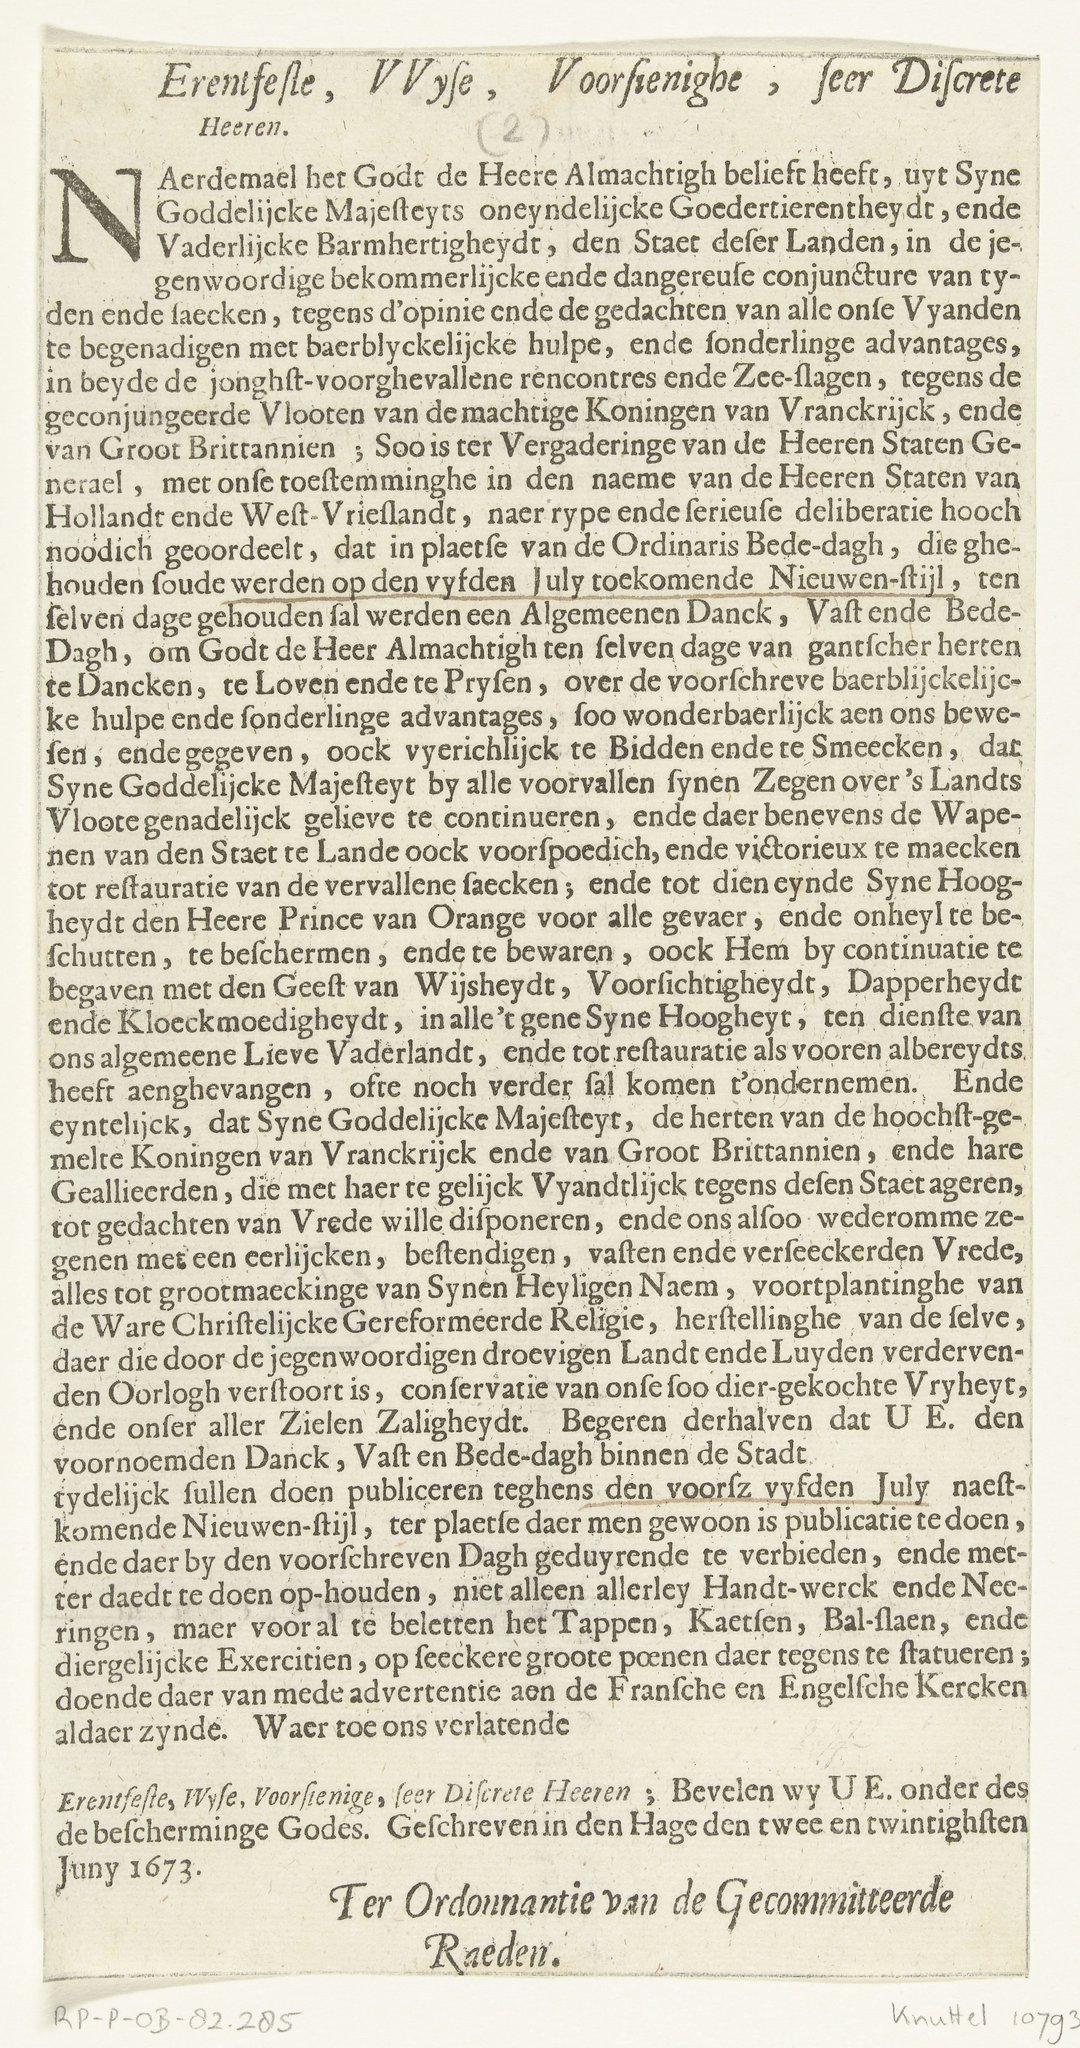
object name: text sheet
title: Uitschrijving door de Staten-Generaal van een dankdag voor de overwinningen in de zeeslagen van juni 1673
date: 1673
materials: paper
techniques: letterpress printing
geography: northern netherlands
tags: first battle of schooneveld, second battle of schooneveld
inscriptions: date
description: Uitschrijving op 22 juni door de Staten-Genaeraal van een dank-, vast- en gebedsdag op 5 juli voor de overwinningen in de zeeslagen op Schoonevelt op 7 en 14 juni 1673 behaald door de vloot van de Republiek onder Michiel de Ruyter en Cornelis Tromp op de gecombineerde Engels-Franse vloot onder Prins Rupert en graaf Jean d'Estrées. Tekst in één kolom.